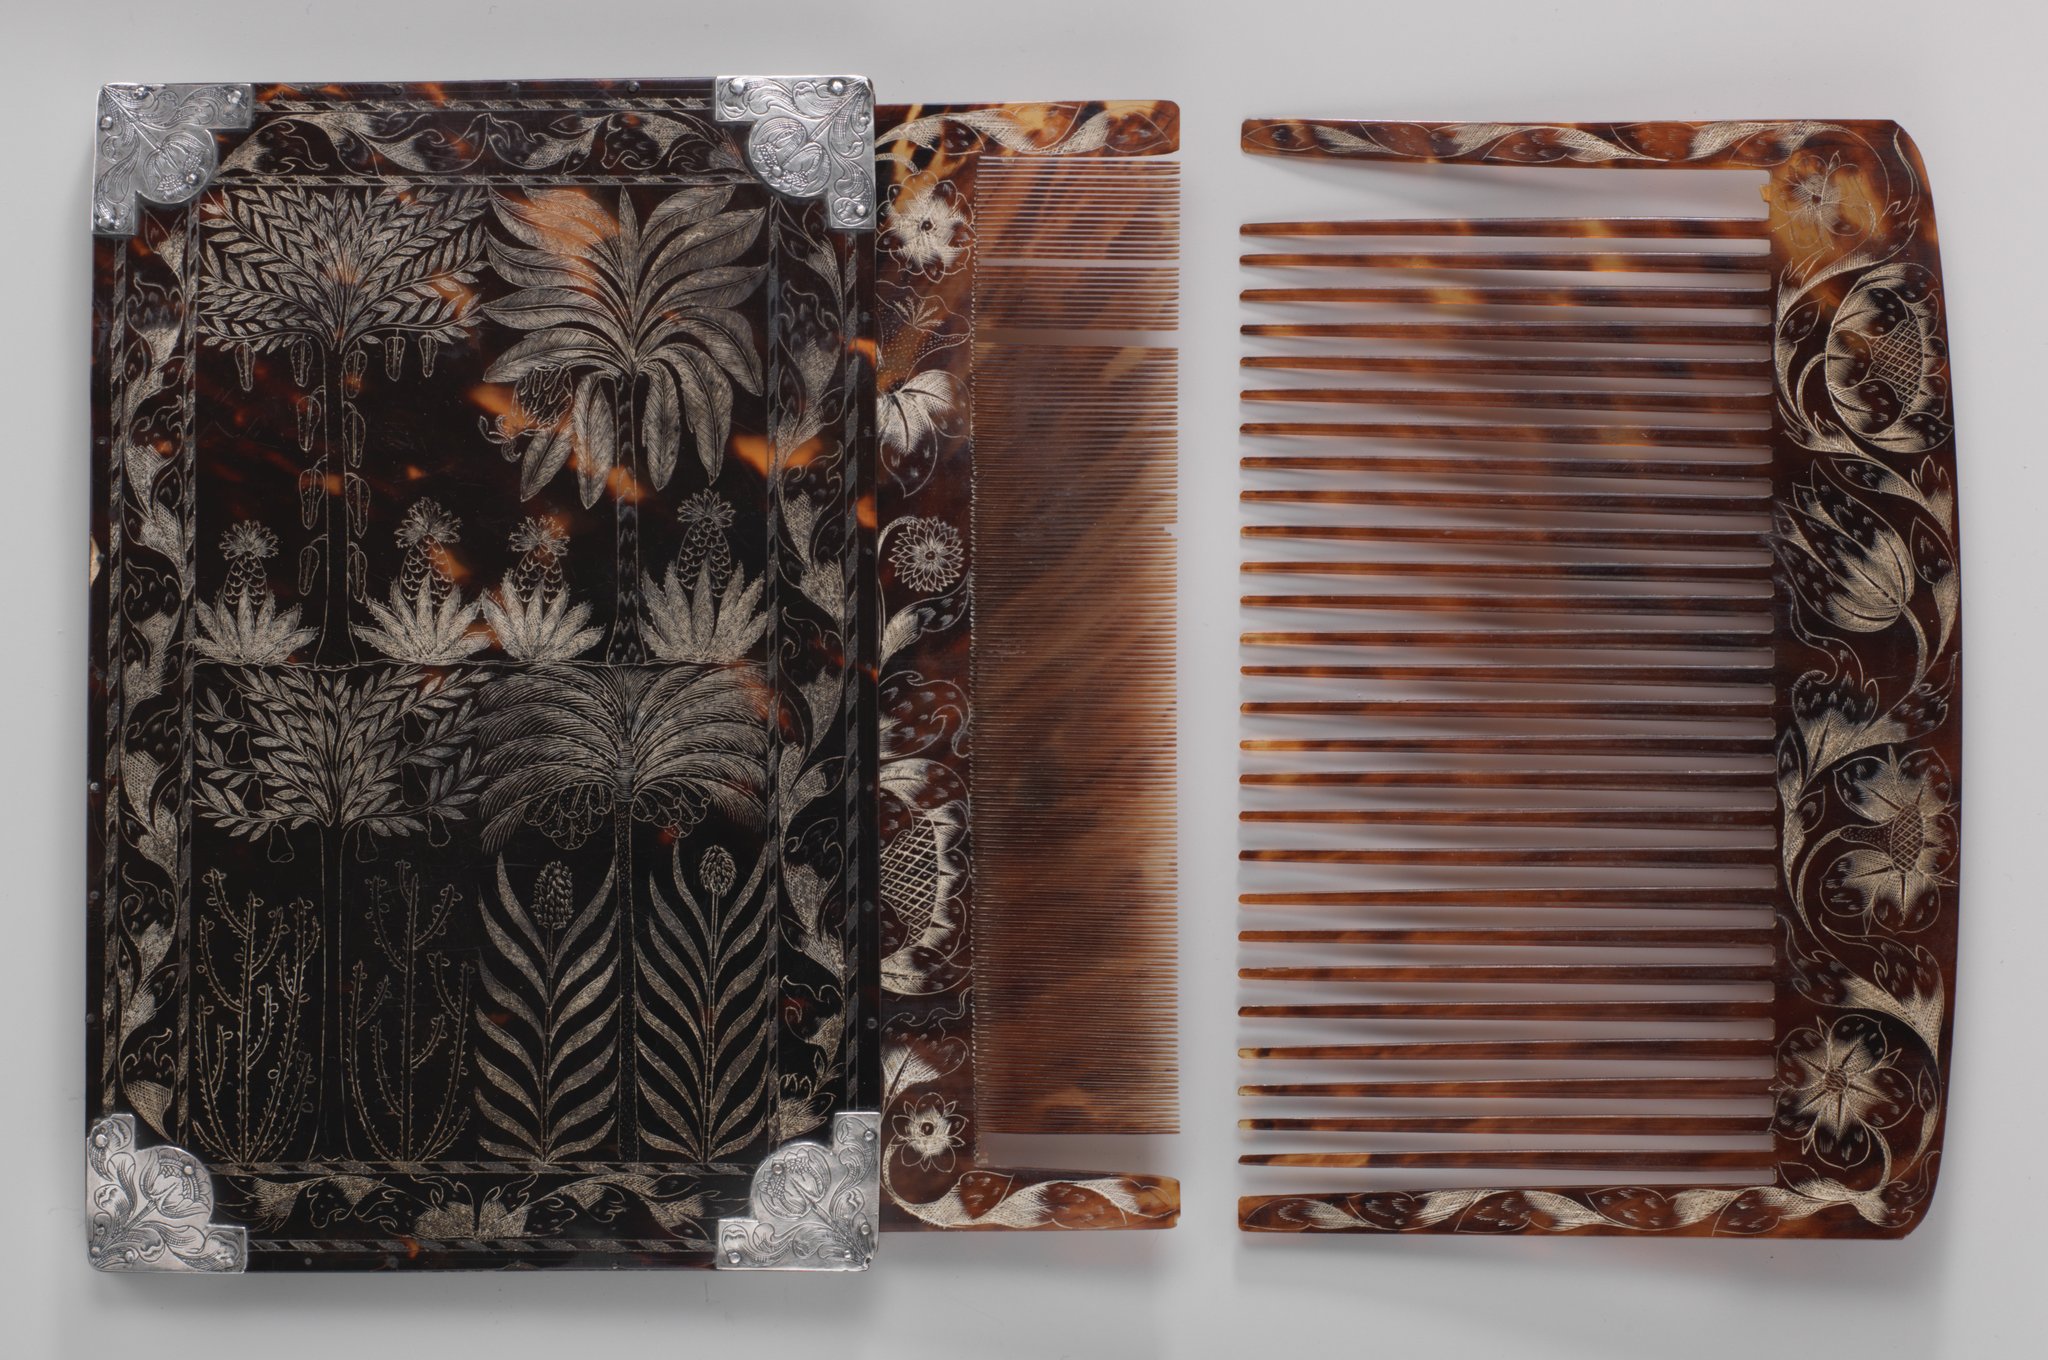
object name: comb case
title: Comb case with two wig combs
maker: paul bennett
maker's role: artist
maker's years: 1673-1688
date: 1685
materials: shell, silver